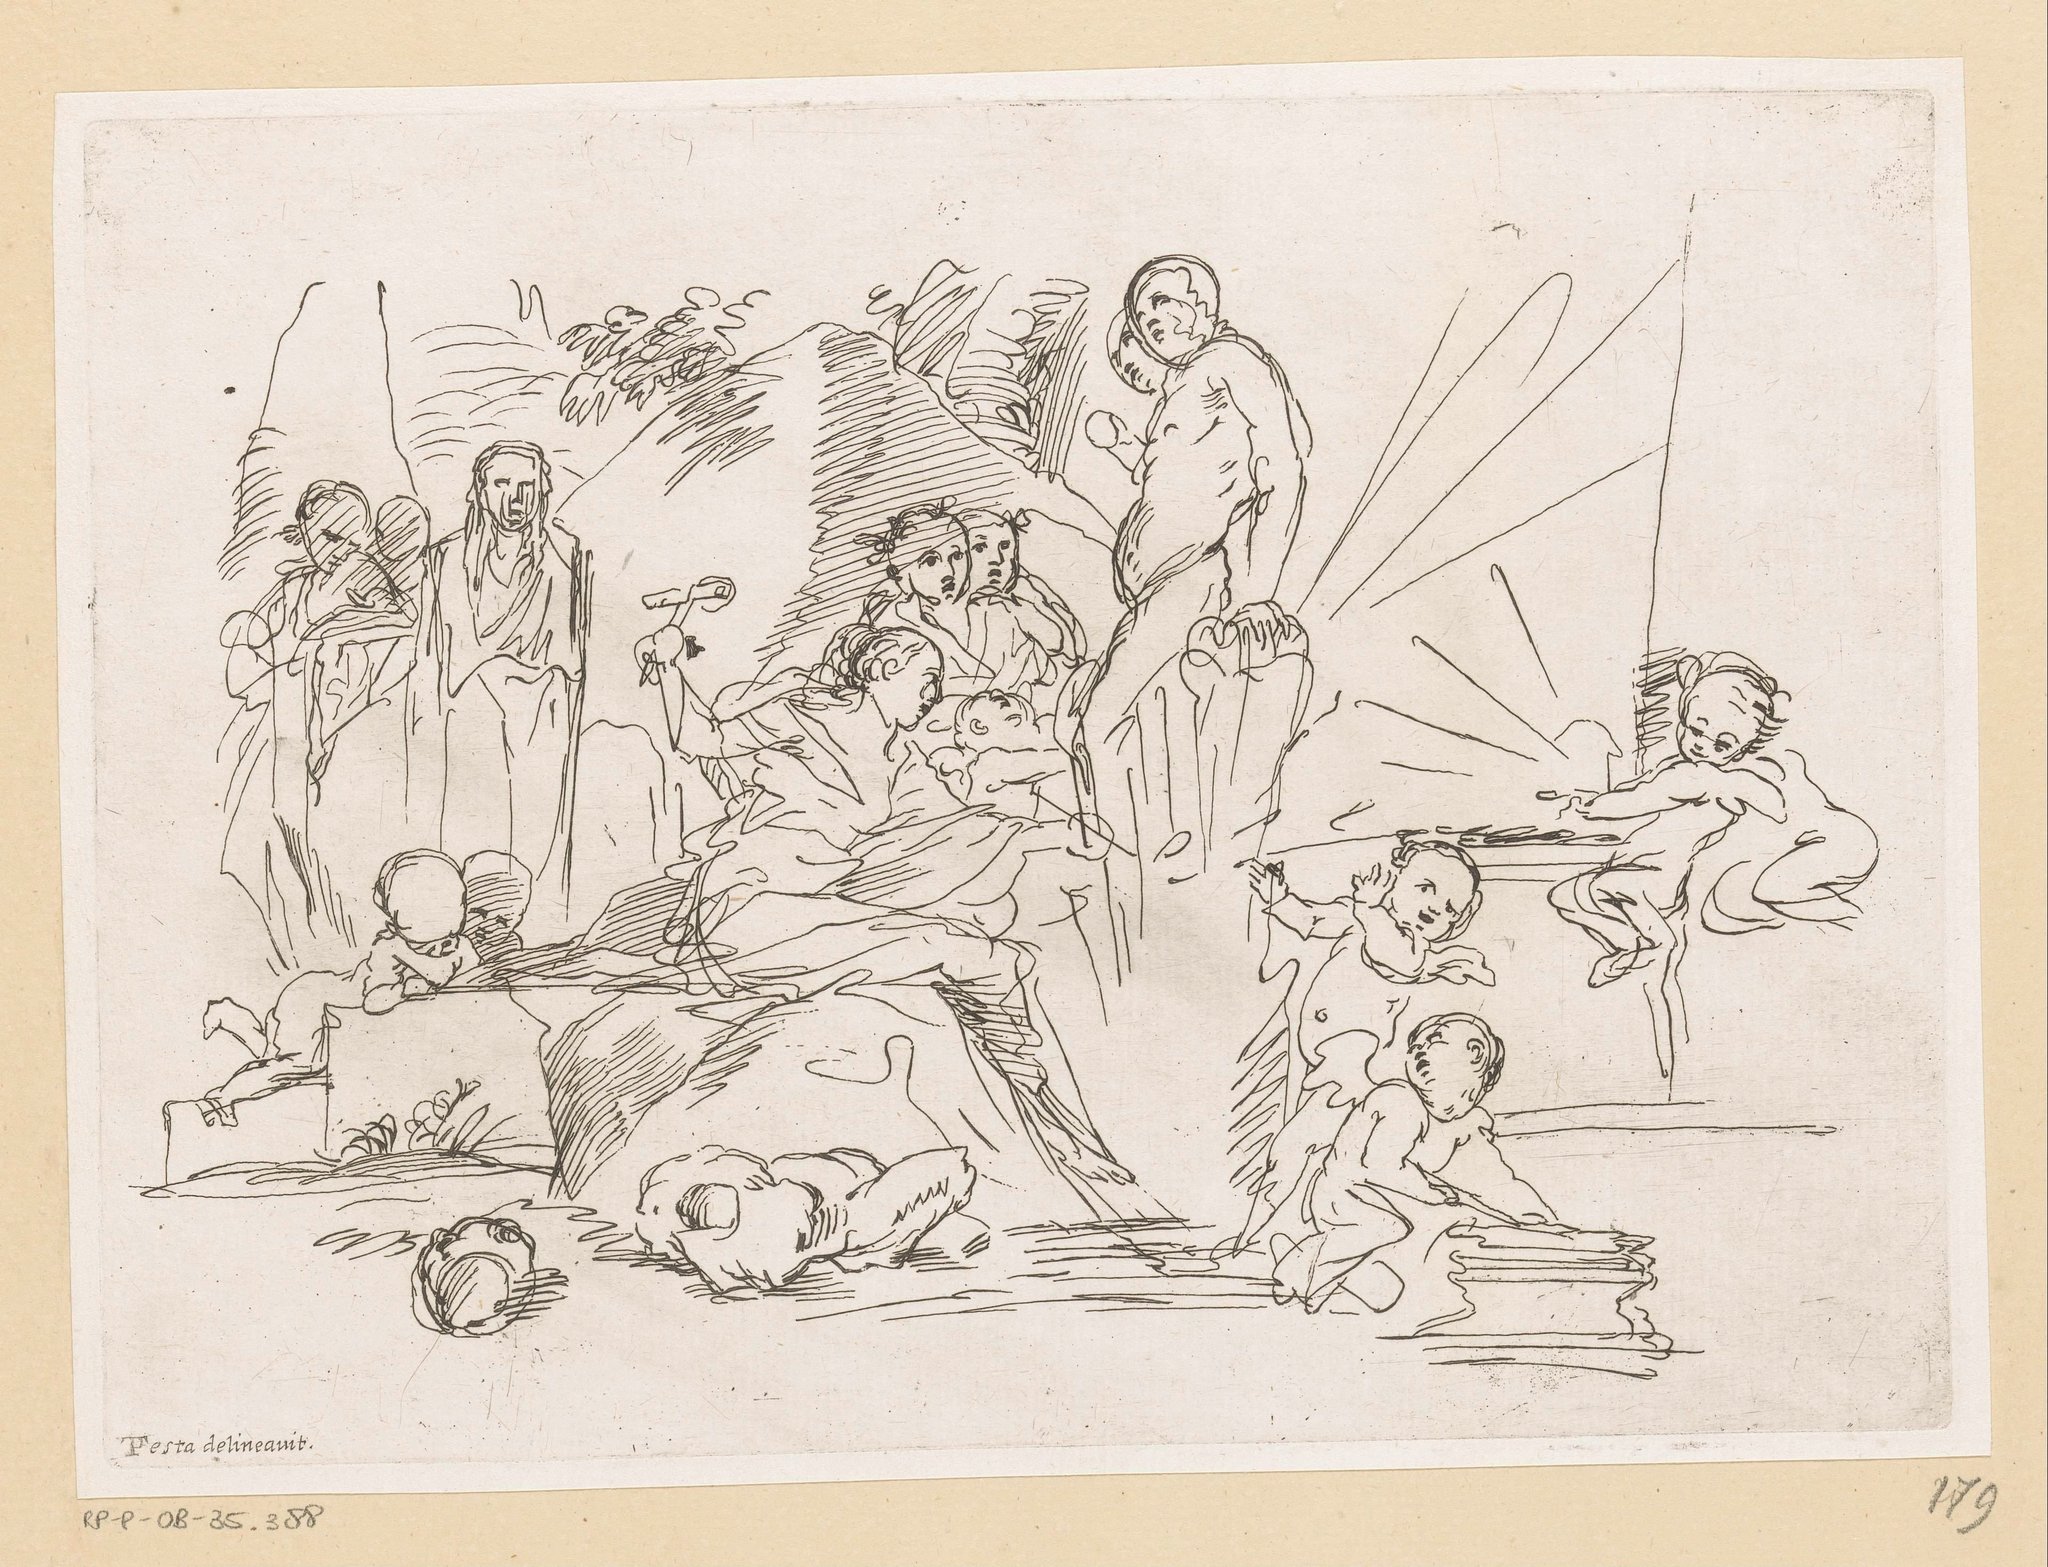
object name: print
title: Vrouw met kruis op rots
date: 1650-1750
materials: paper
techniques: etching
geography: italy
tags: altarcross, crucifix, cupids: 'amores', 'amoretti', 'putti', rocks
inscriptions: collector's mark: Lugt 240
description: Een vrouw met een kruis in de hand, zittend op een rots. Ze wordt omringd door putti en andere figuren.